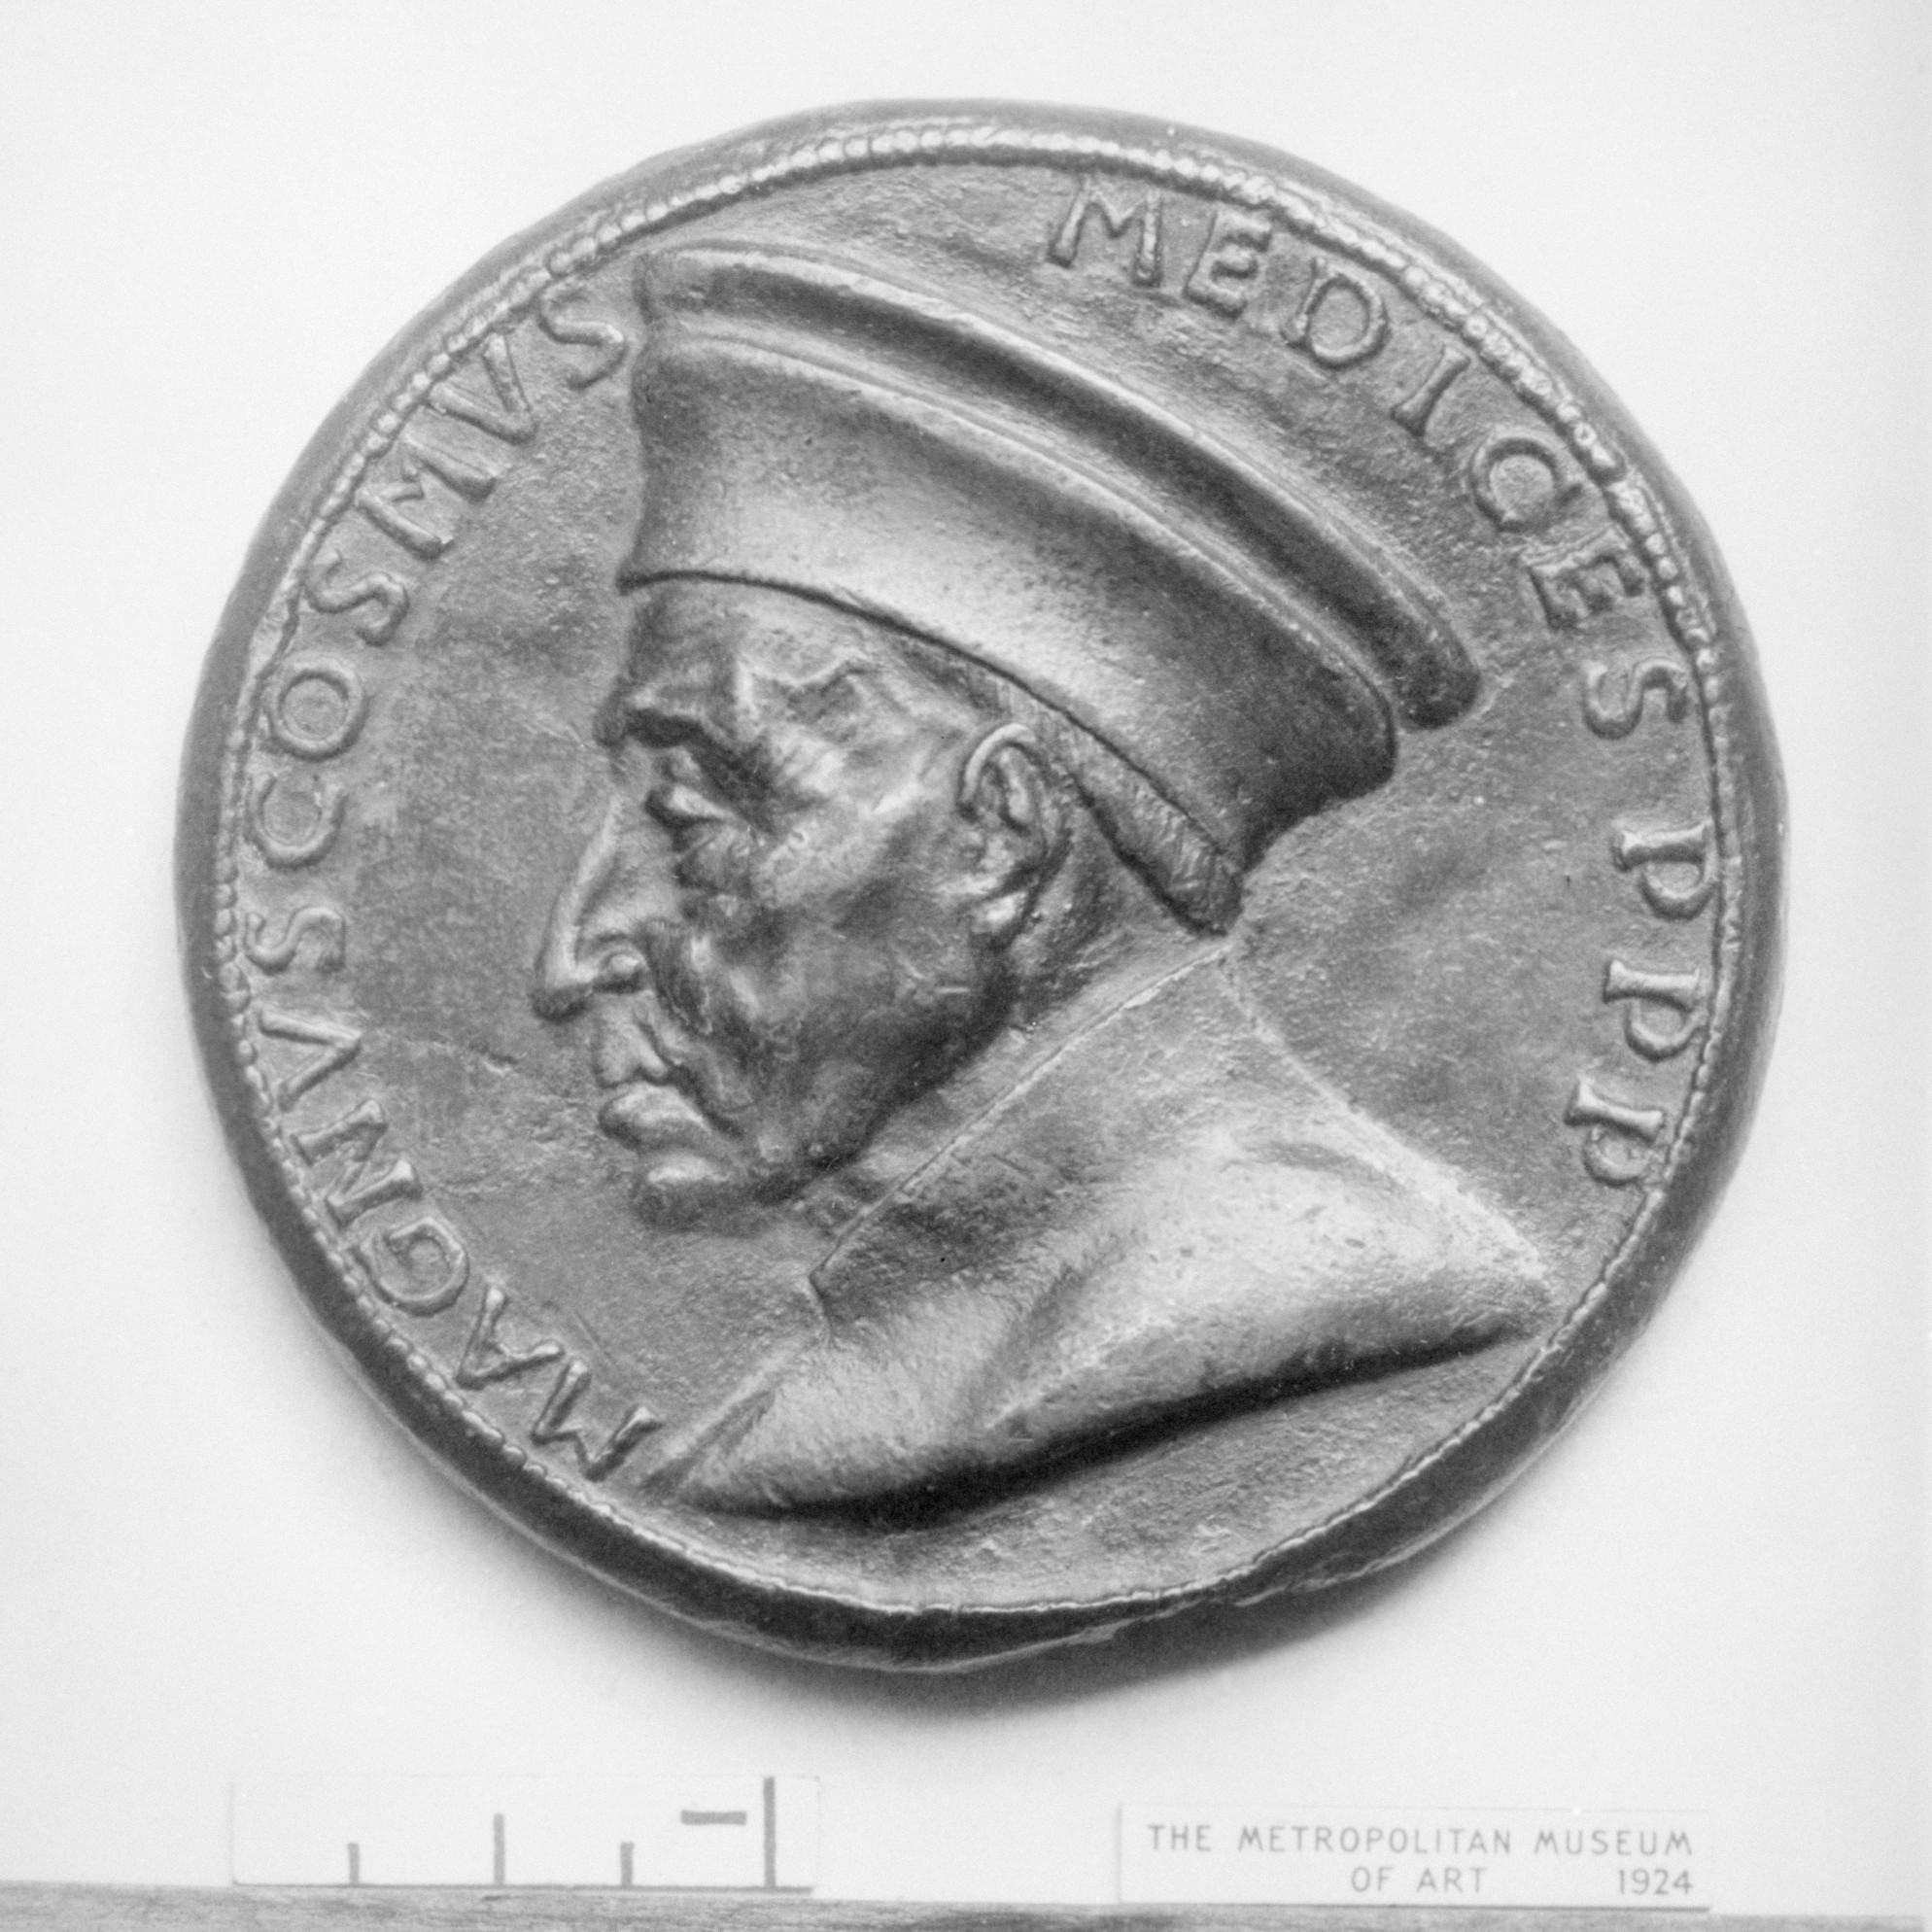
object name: medal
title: Cosimo de' Medici the Elder (1389–1464)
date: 1465-1469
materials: bronze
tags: men,profiles